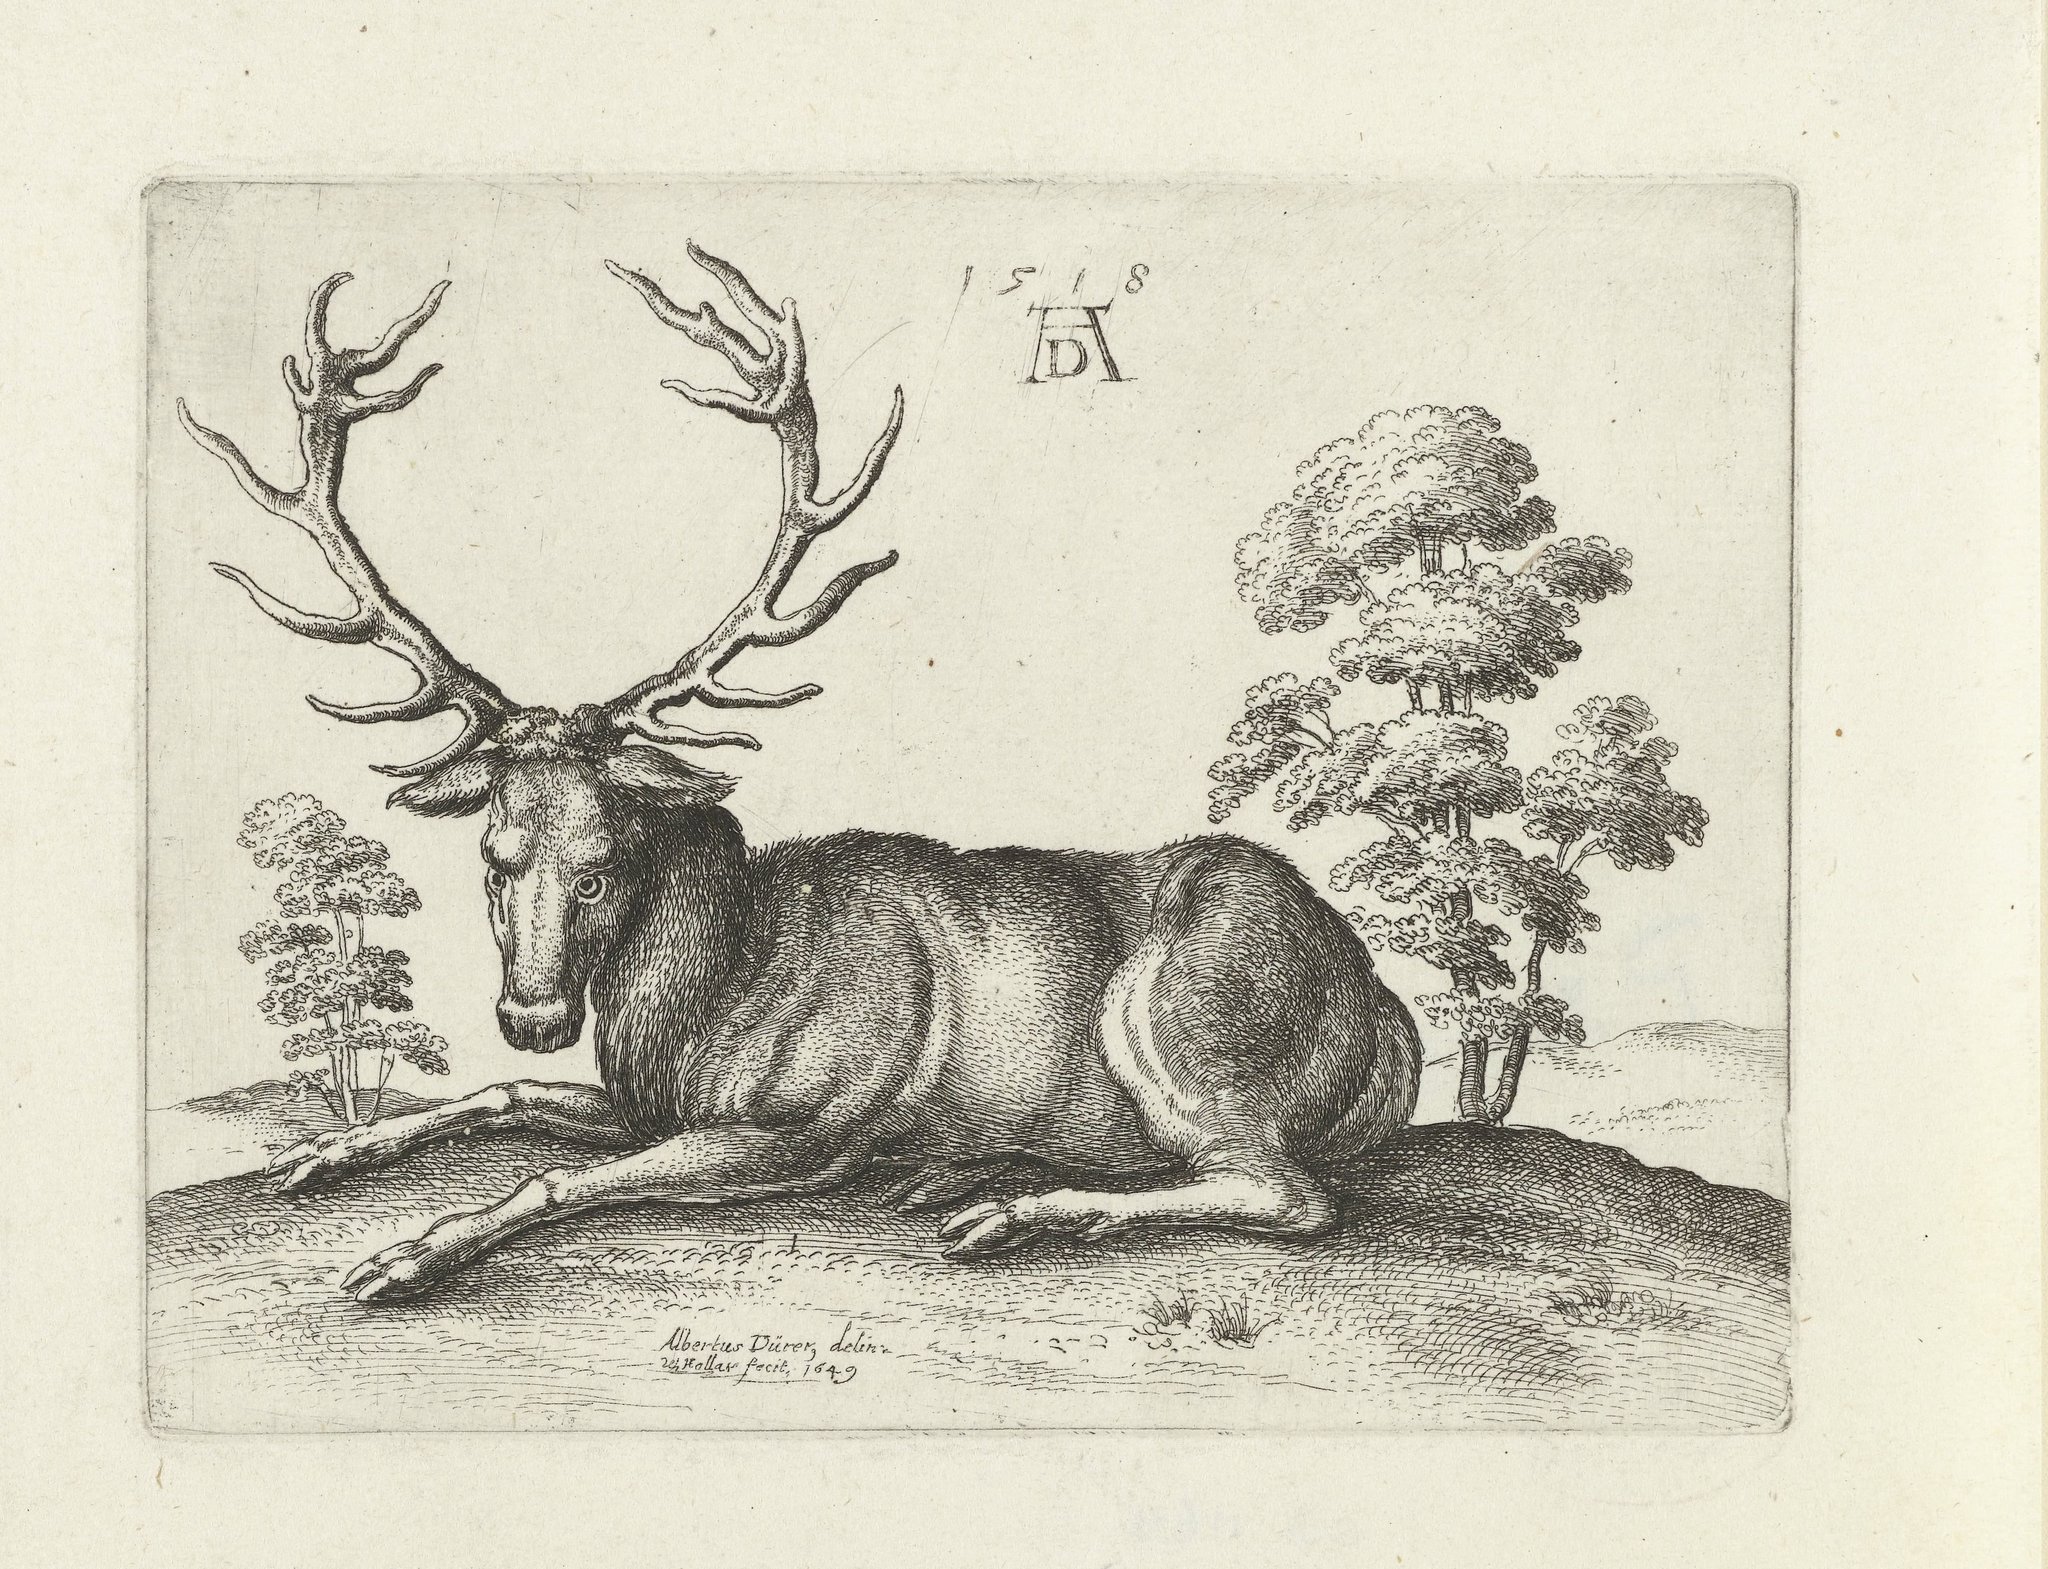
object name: print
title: Liggend hert, naar links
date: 1649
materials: paper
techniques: etching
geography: antwerp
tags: hoofed animals: deer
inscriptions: collector's mark: Lugt 240